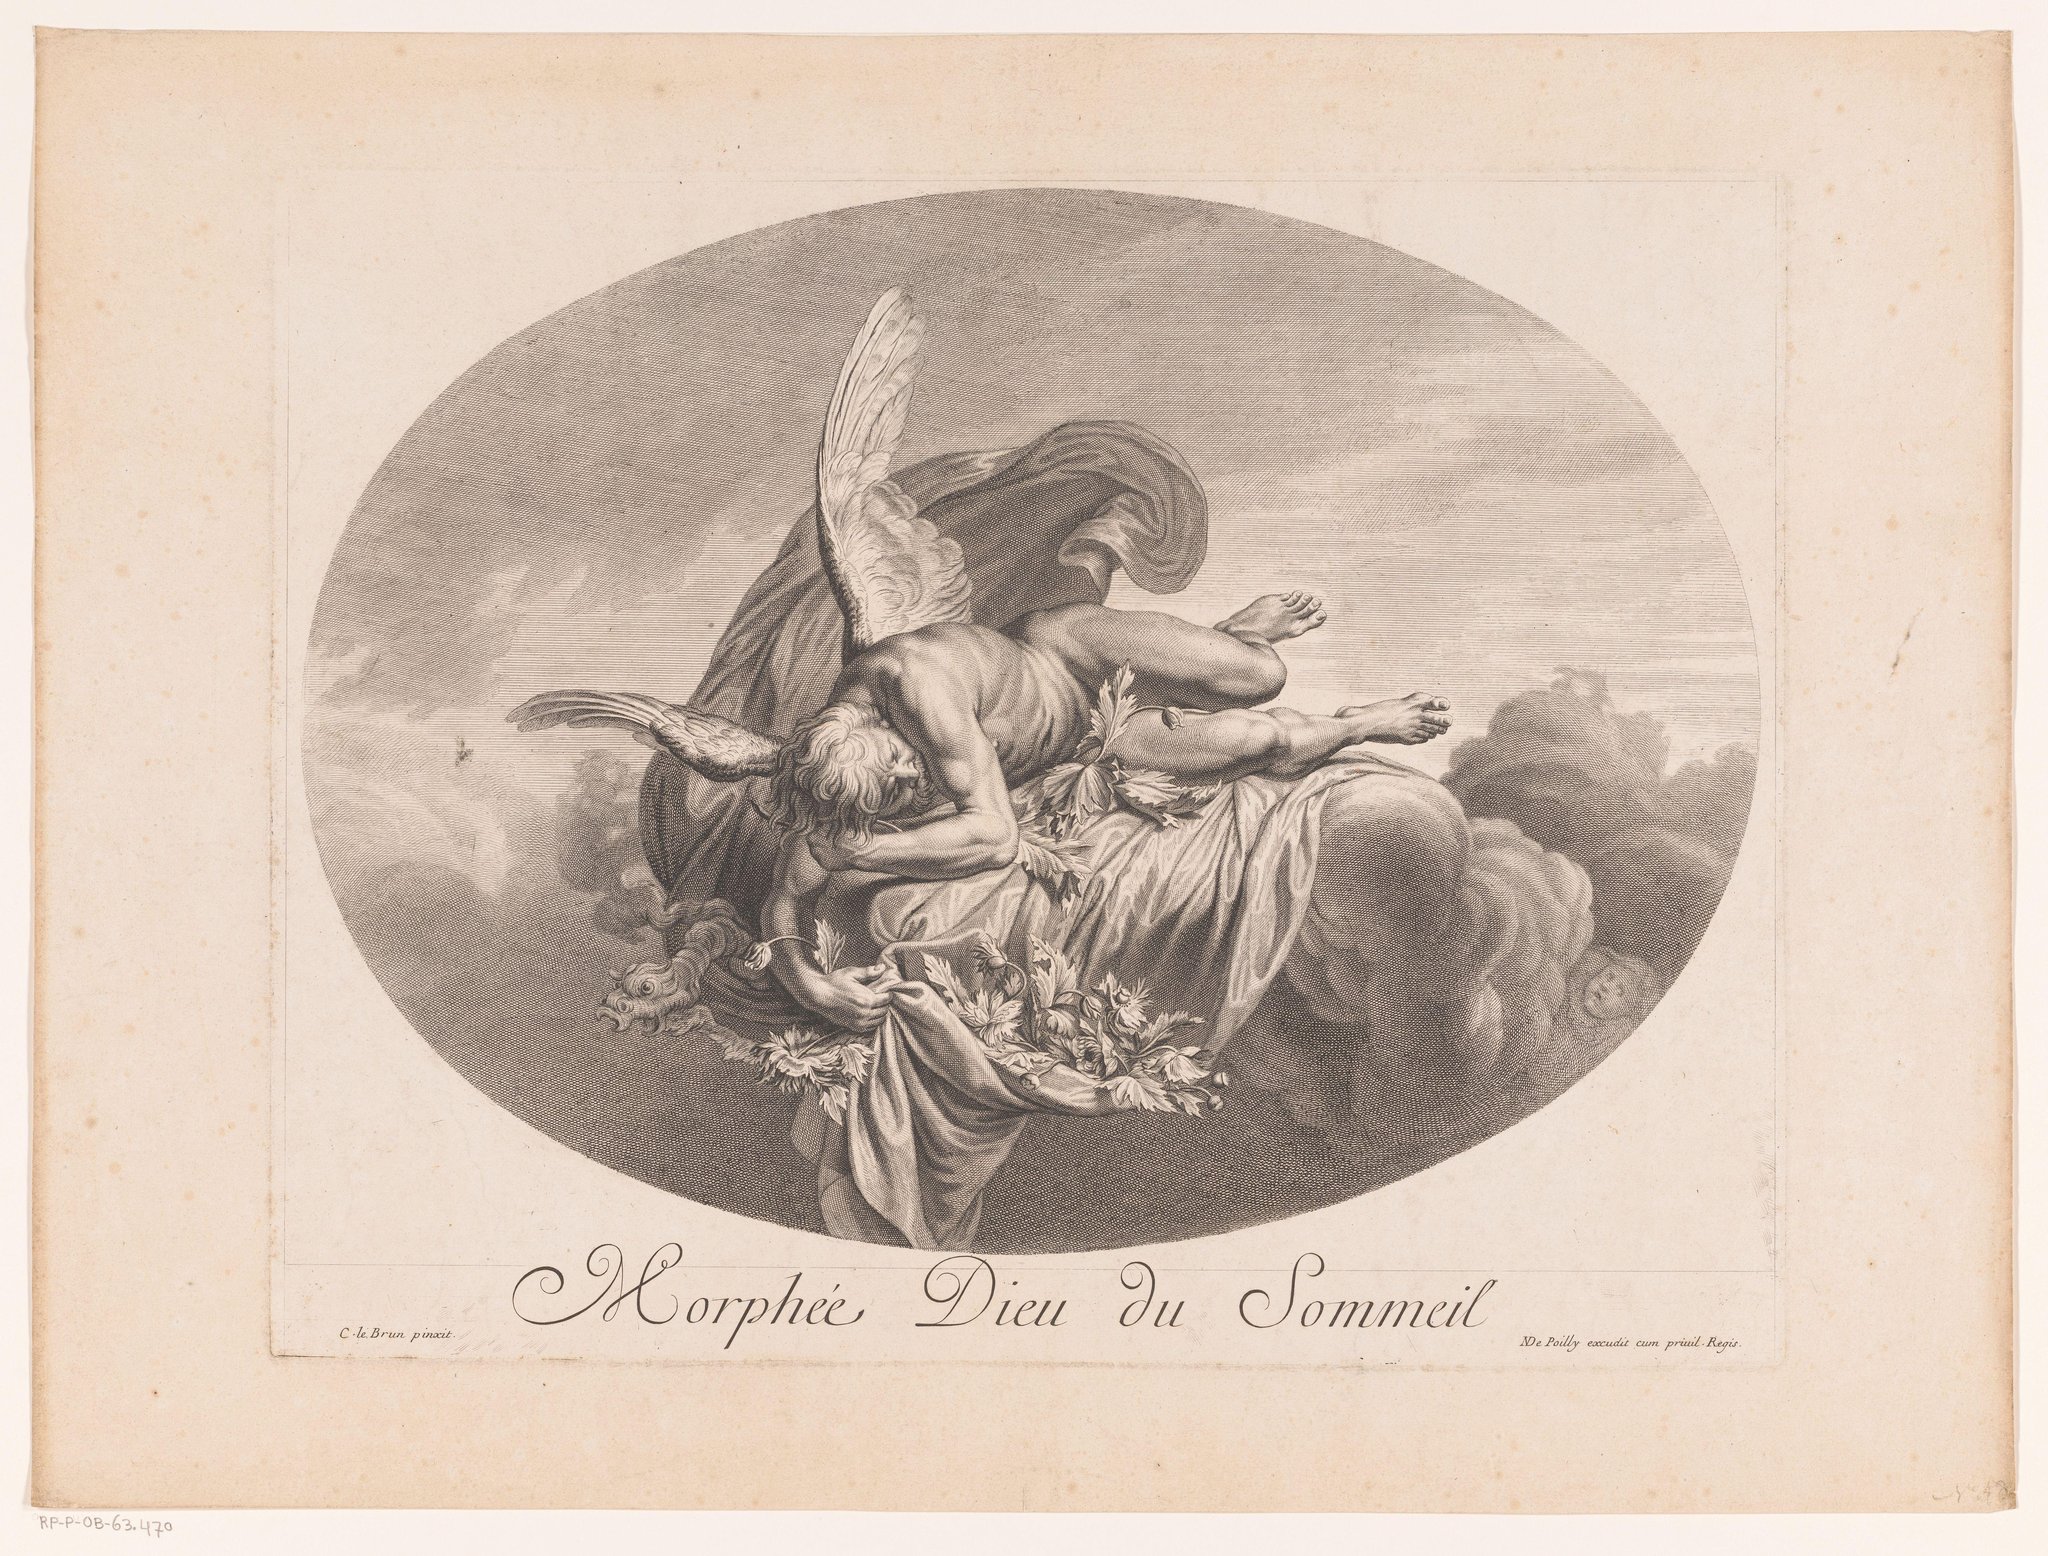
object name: print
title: Morpheus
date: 1636-1696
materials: paper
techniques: etching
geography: france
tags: gods of dream (oneiroi) (morpheus, phobetor, phantasus)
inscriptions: collector's mark: Lugt 240